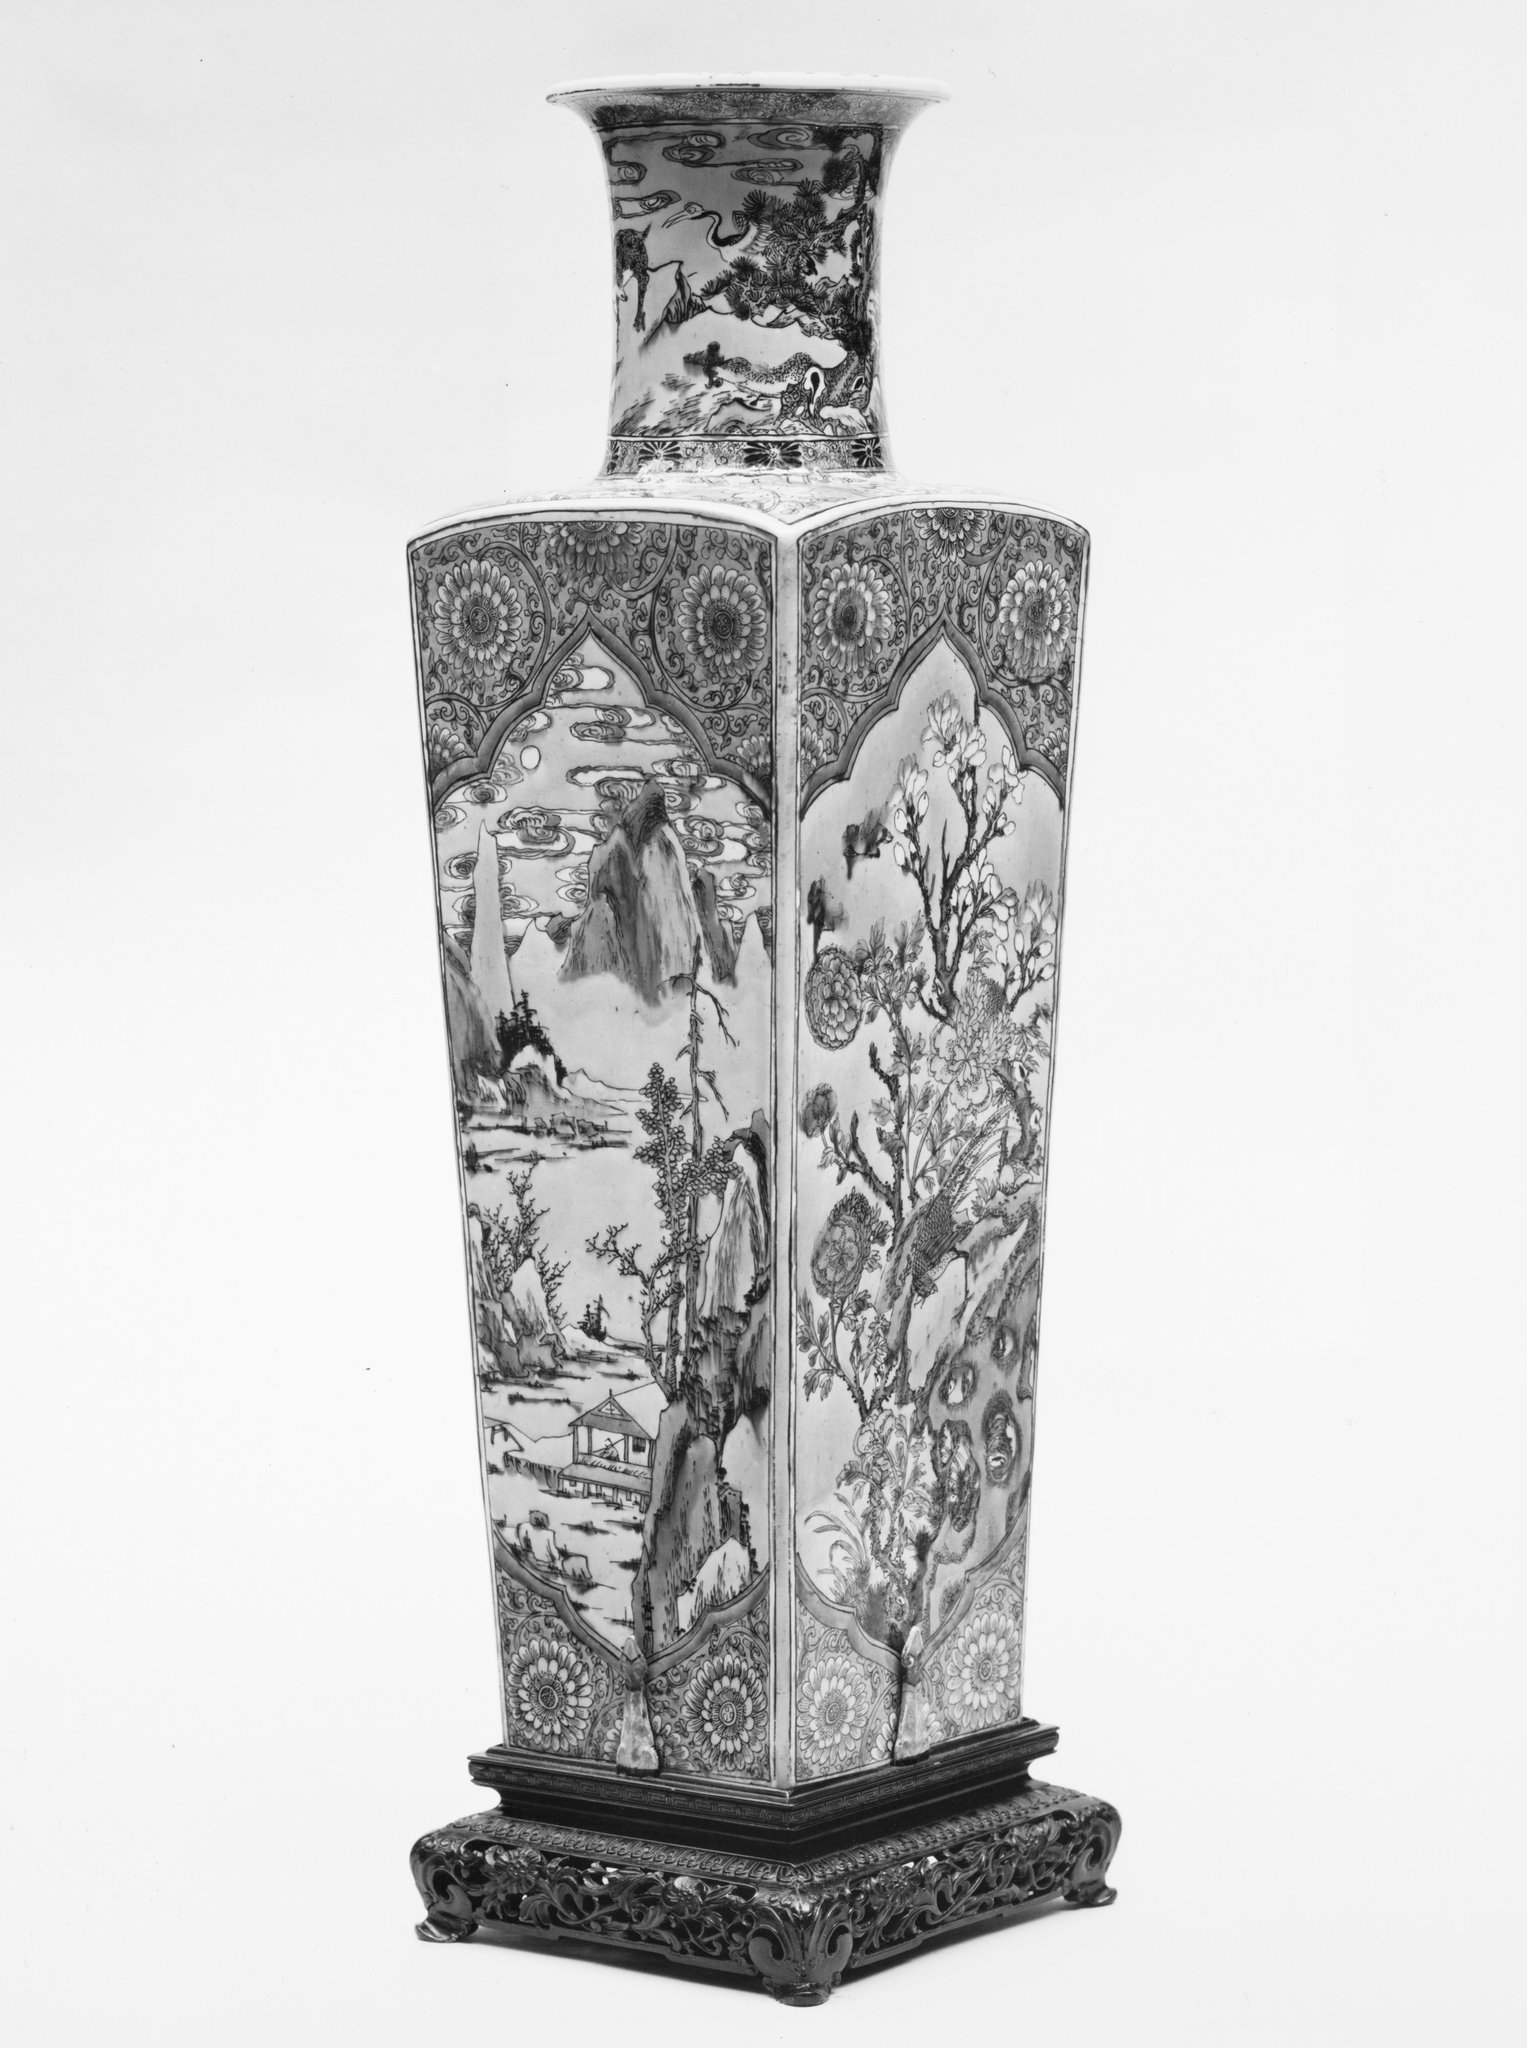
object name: vase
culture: chinese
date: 1667-1733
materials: biscuit, enamel, porcelain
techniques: painting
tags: flowers,landscapes